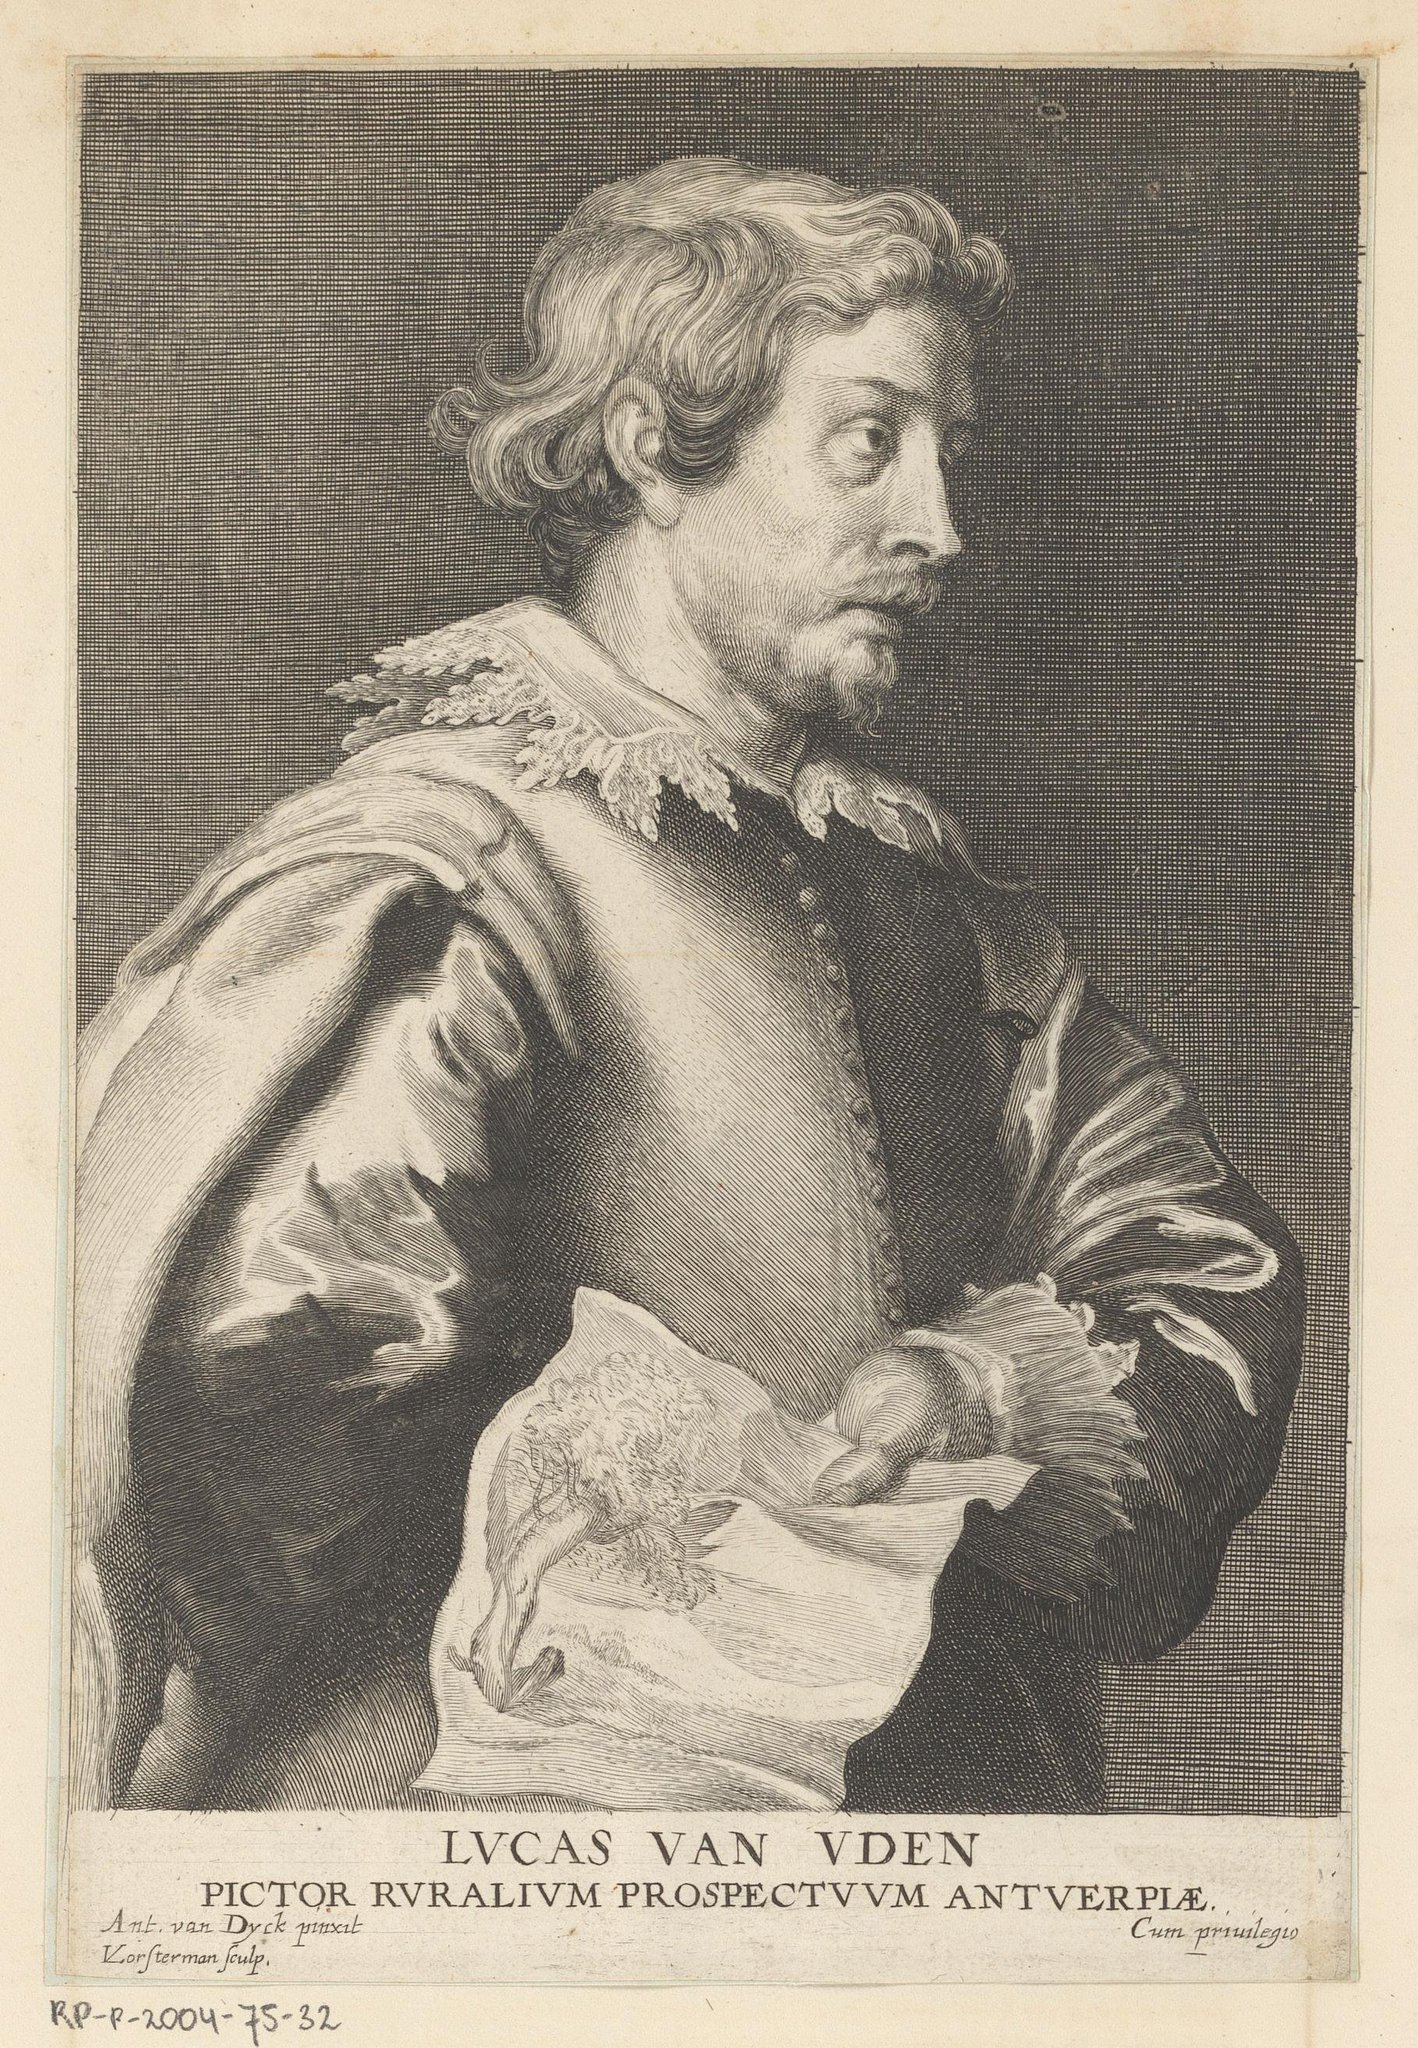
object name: print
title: Portret van Lucas van Uden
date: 1645-1646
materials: paper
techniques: engraving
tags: antwerp, print maker, draughtsman, lucas van uden, historical persons, portrait, self-portrait of painter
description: Prent uit: Iconographie ou Vies des Hommes Illustres du XVII. Siecle (...). 2 dln. Amsterdam: Johann Caspar Arkstee, Leipzig: Henricus Merkus, 1759. Prent is ontworpen voor de serie getiteld 'Iconographie' samengesteld door Anthony van Dyck en uitgegeven in 1645-1646. De samensteller heeft deze prent in het album geplakt als illustratie bij: Pilkington, Matthew en Johann Heinrich Füssli. A dictionary of painters, from the revival of the art to the present period. 4 dln. Londen: John Crowder, 1805, dl. 4, p. 593.